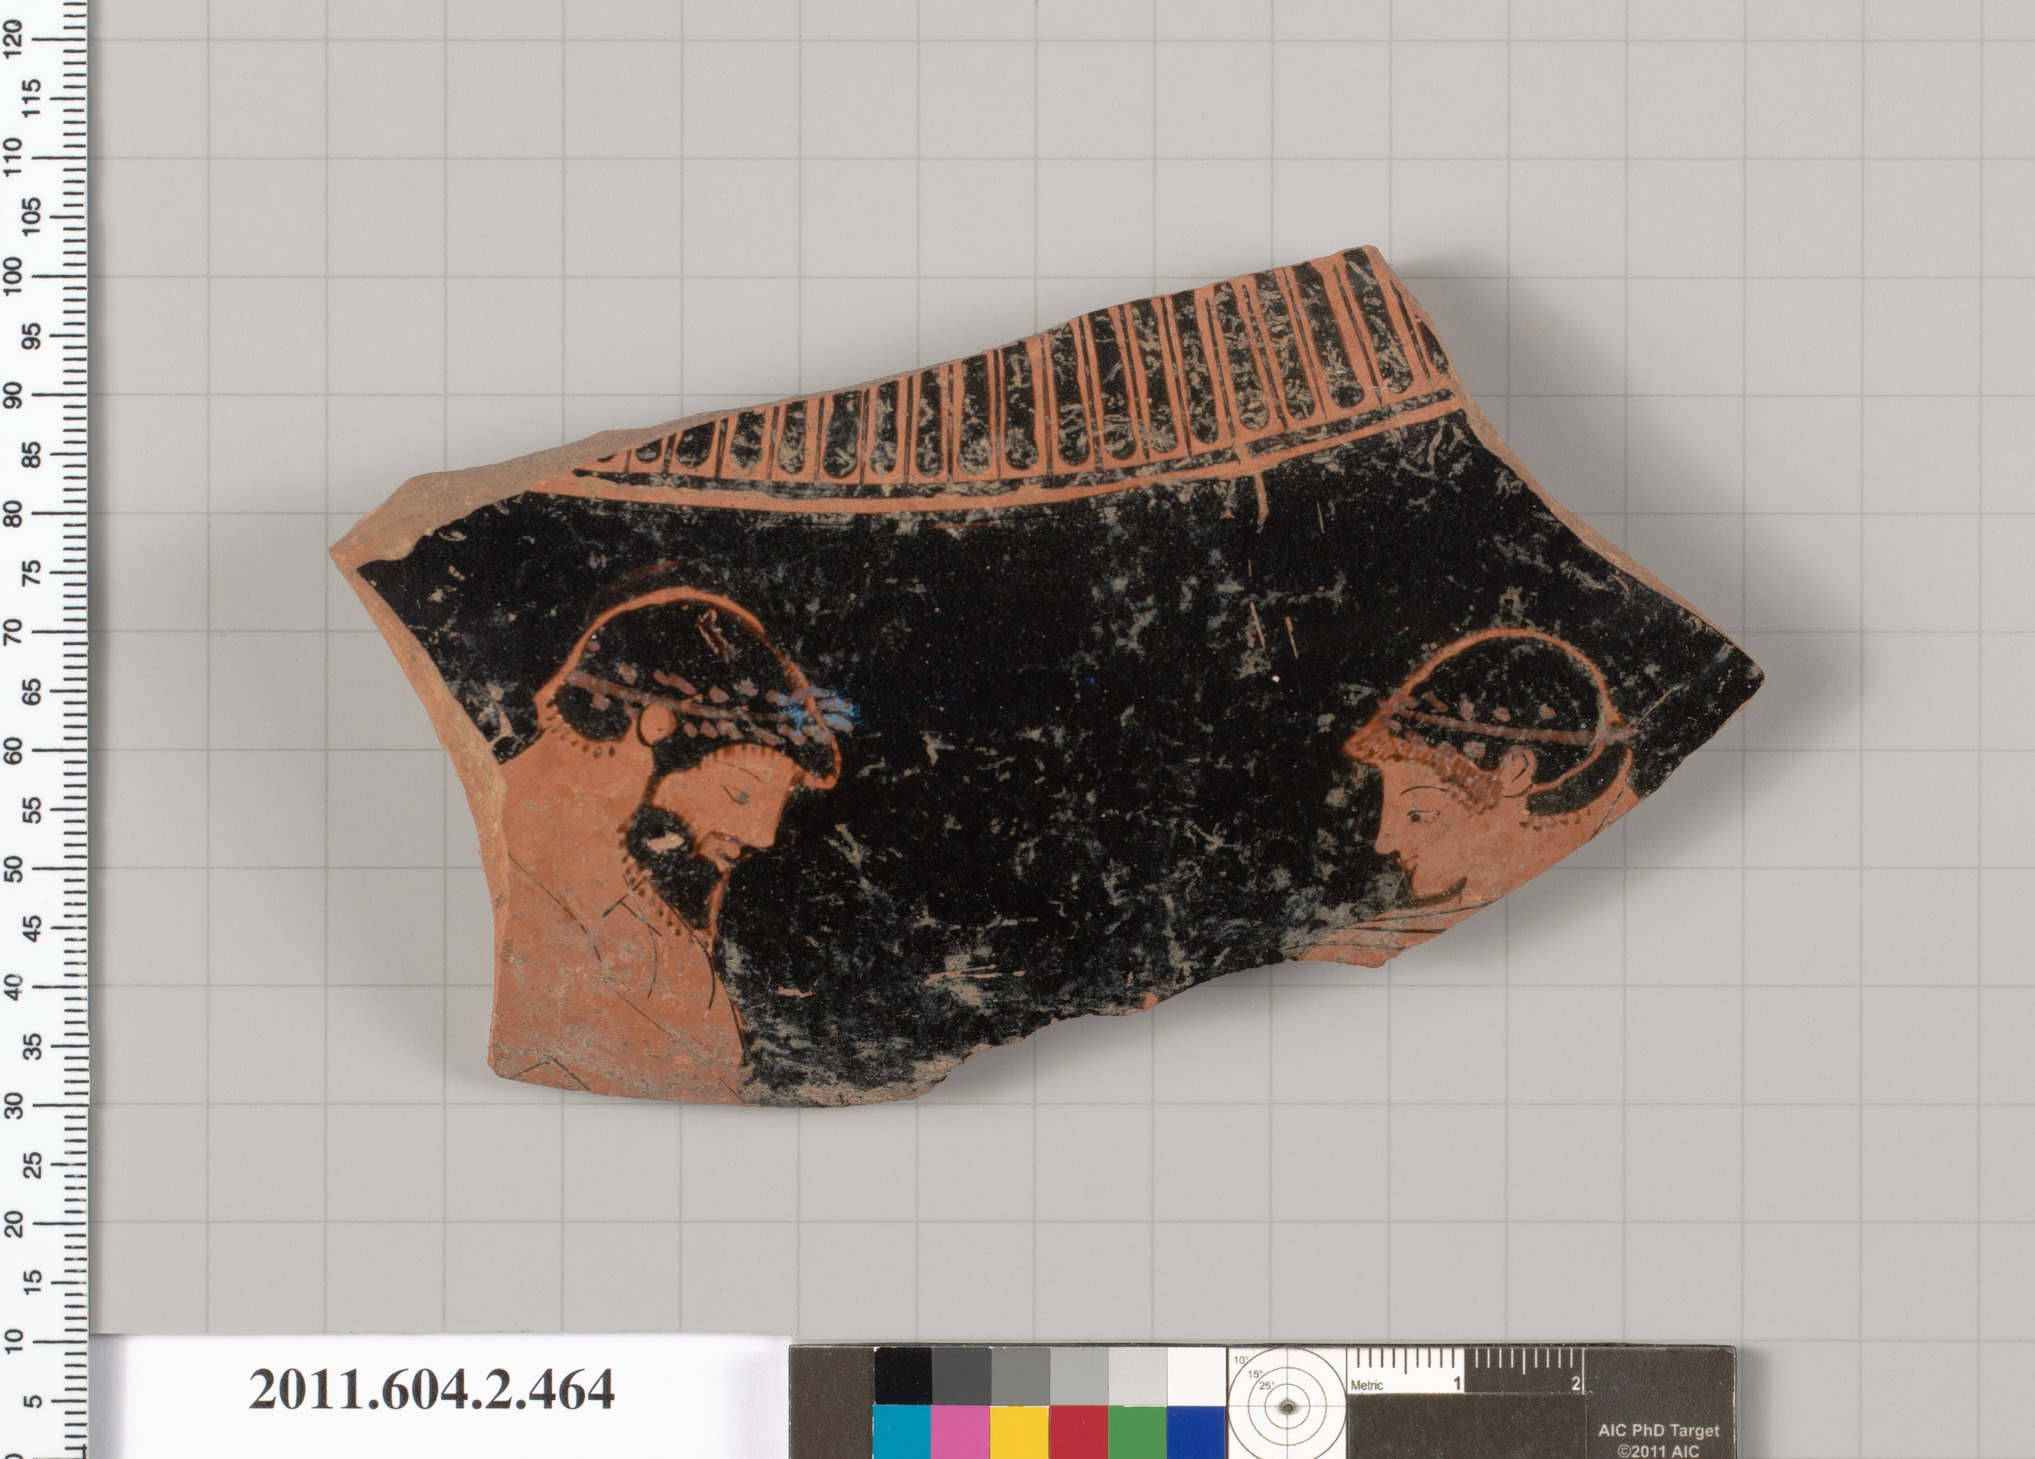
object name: column krater fragment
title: Terracotta fragment of a column-krater (bowl for mixing wine and water)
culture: greek, attic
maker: flying-angel painter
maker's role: artist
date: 460-440 BCE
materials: terracotta